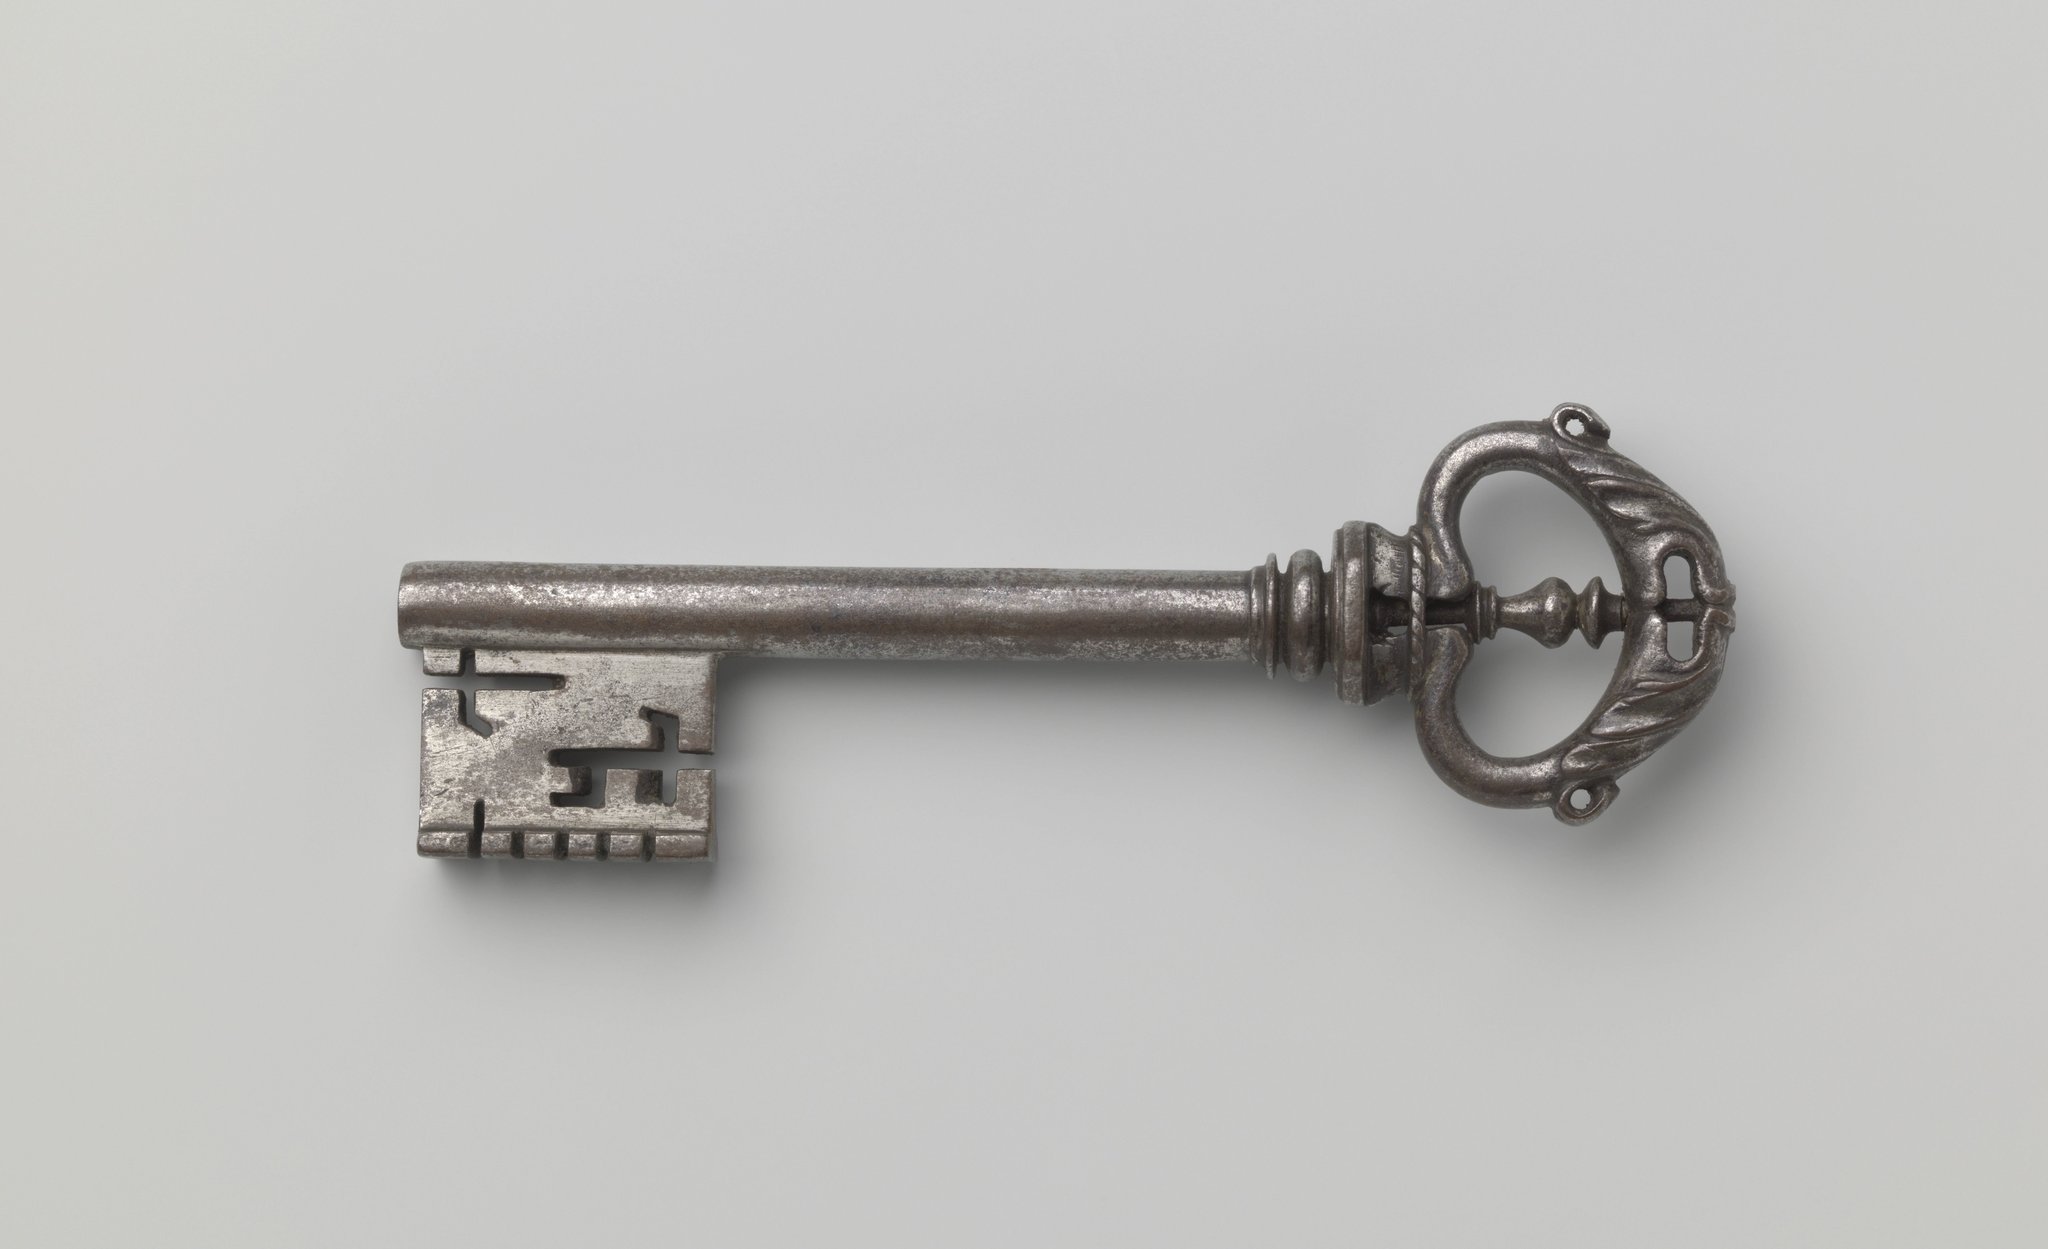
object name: key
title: Sleutel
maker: mathurin jousse (ii)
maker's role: architect, slotenmaker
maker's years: 1607-1692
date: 1607-1692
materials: iron